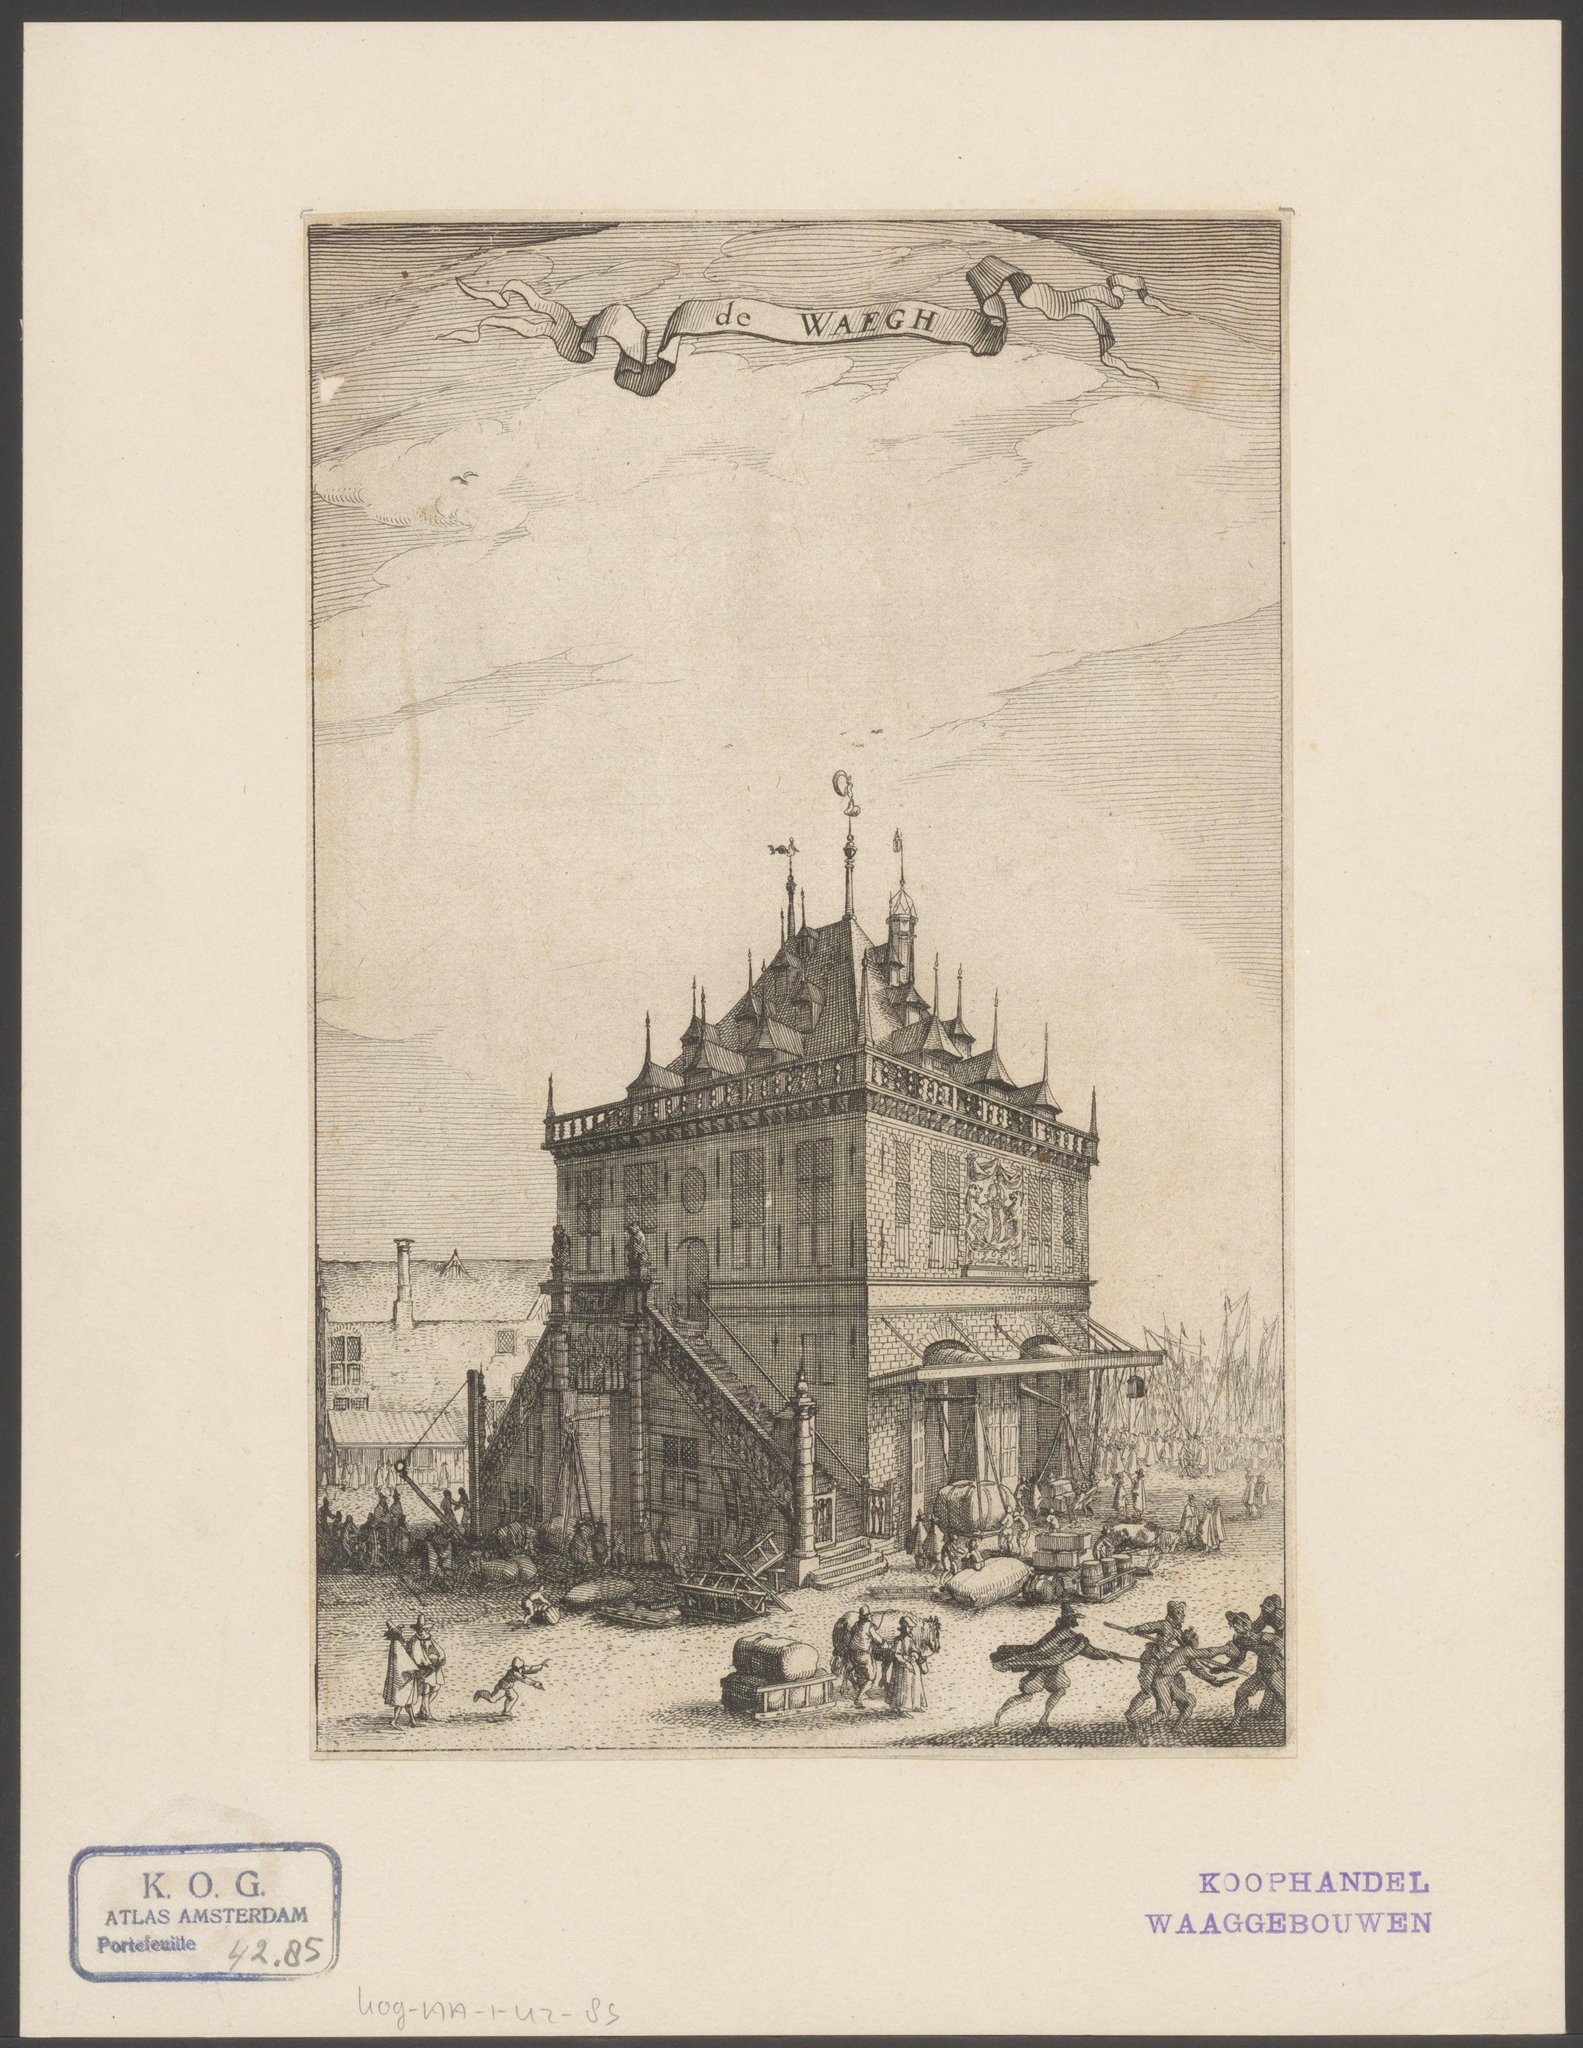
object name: print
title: De Waegh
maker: claes jansz. visscher (ii)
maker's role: draughtsman, print maker, publisher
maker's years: 1586-1652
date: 1601-1612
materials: paper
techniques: engraving, etching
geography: amsterdam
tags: sleigh, sledge (non-sport), weigh-house, amsterdam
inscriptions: collector's mark: Lugt 1461b, stamp: ‘Koophandel Waaggebouwen’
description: Oorspronkelijk van één plaat gedrukt met een voorstelling van het Oude Stadhuis op de Dam (zie RP-P-AO-21-2 en RP-P-1884-A-7655). Prent in zijn geheel komt ook voor in enkele exemplaren van: Guicciardini, Lodovico. Beschryvinghe van alle de Neder-landen, anderssins ghenoemt Neder-Duytslandt (…). Amsterdam: Willem Janszoon Blaeu, 1612. En in enkele exemplaren van latere uitgaven van deze publicatie, uitgegeven door Blaeu (1613) en Johannes Janssonius (1624, 1625, 1646 en 1648). Zie ook RP-P-AO-23-1 en RP-P-AO-23-13.